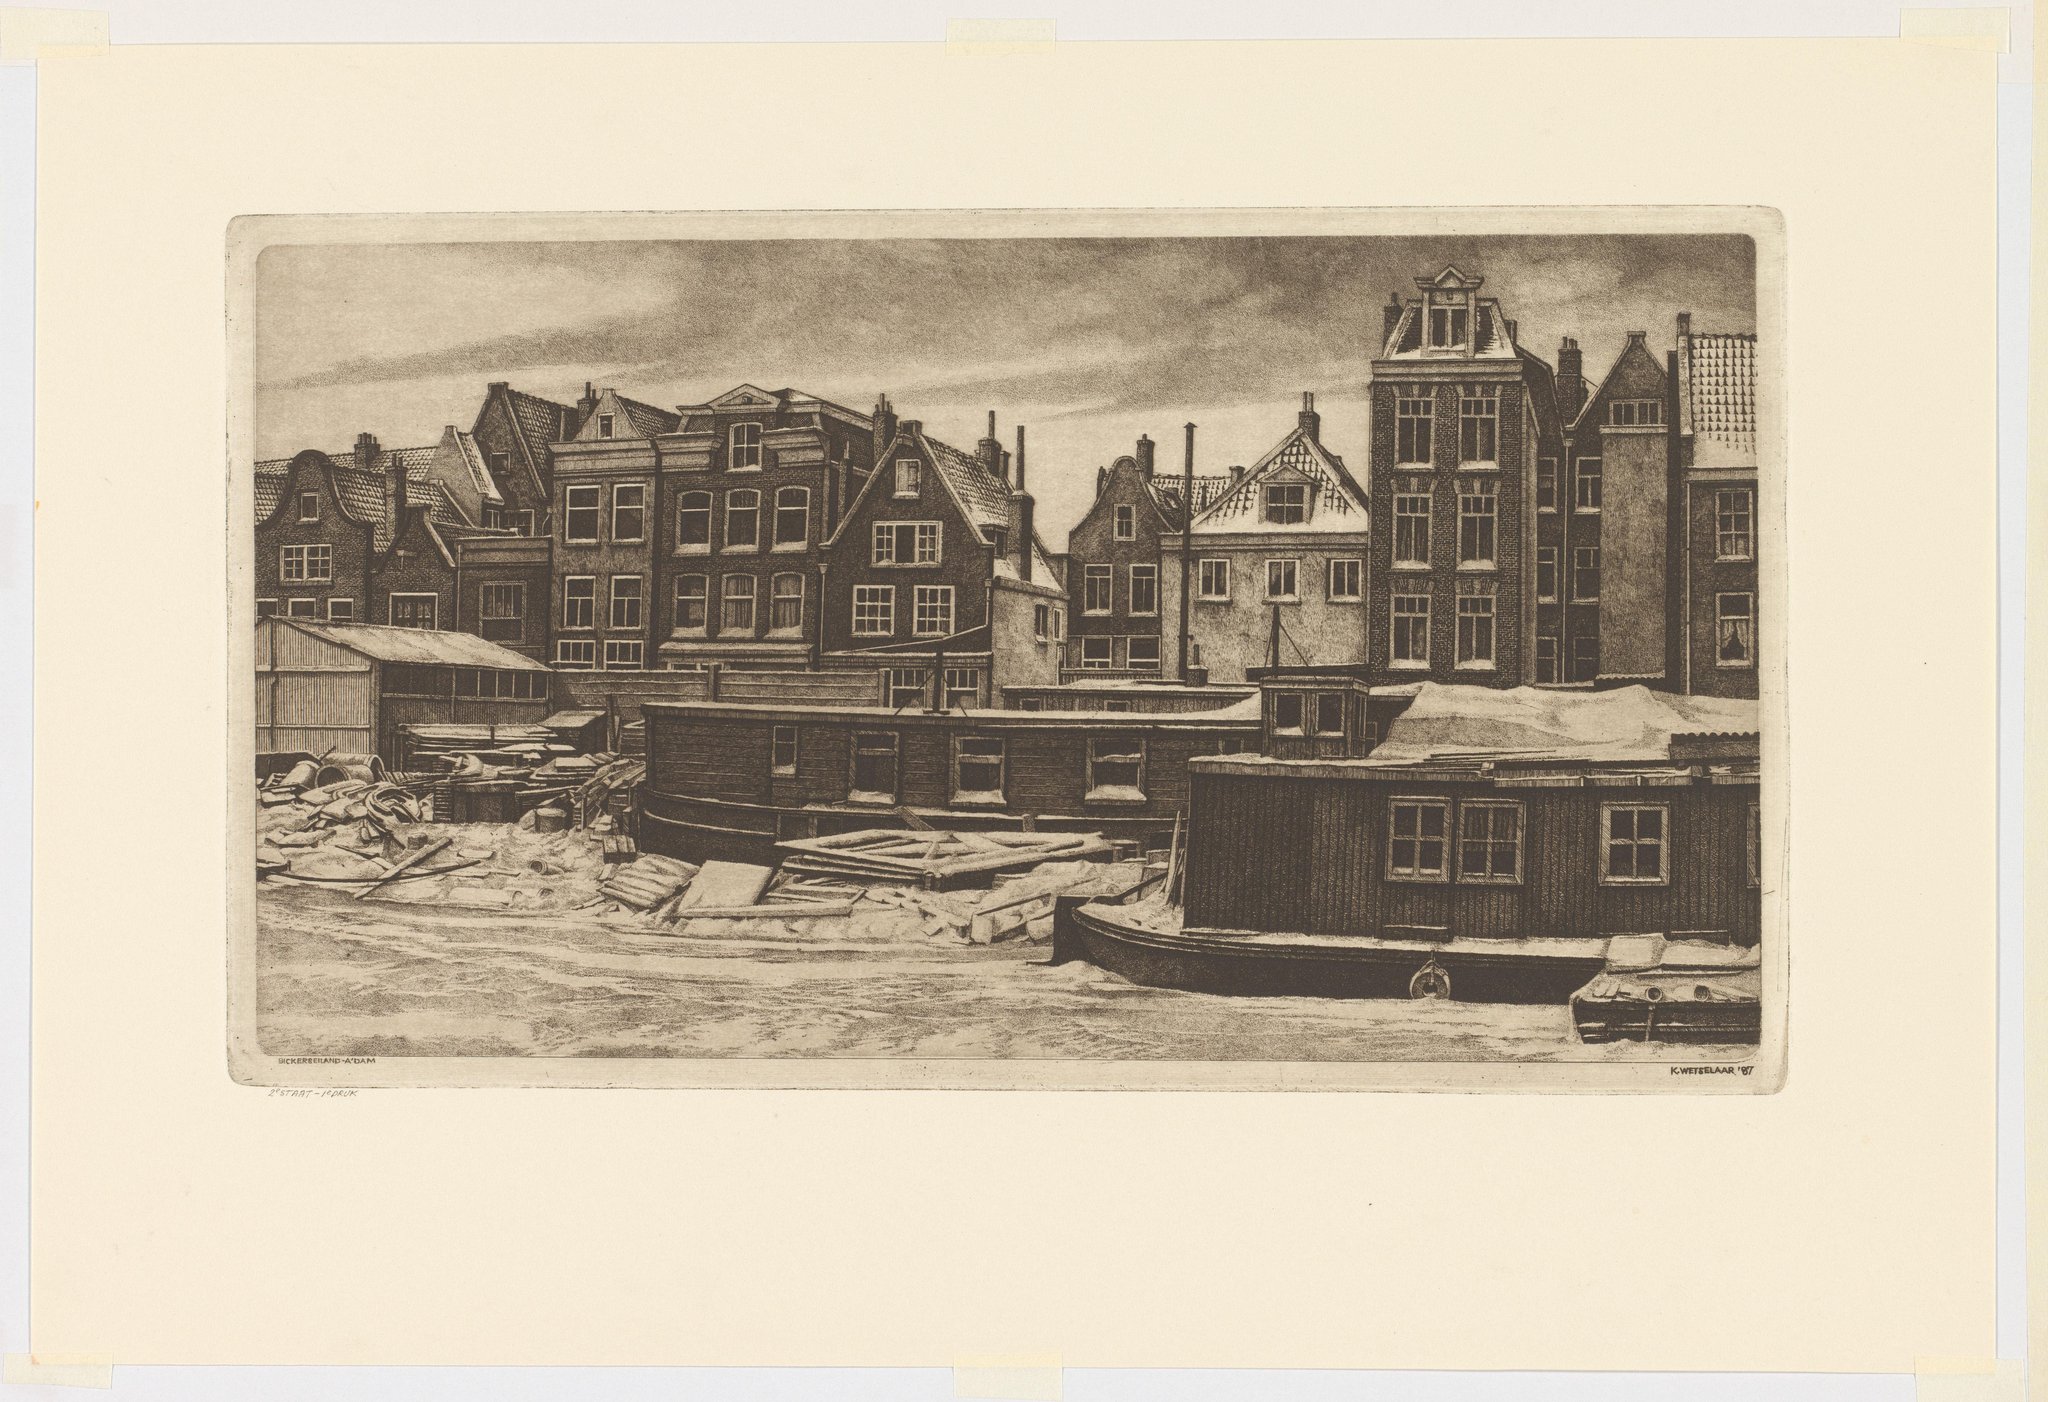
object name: print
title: Bickerseiland - A'dam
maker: karel wetselaar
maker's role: print maker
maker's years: 1935-2017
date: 1987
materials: paper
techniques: etching, retroussage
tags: façade (of house or building), quay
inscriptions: inscription: ‘2e staat - 1e druk’, signature and date: ‘K. Wetselaar '87’